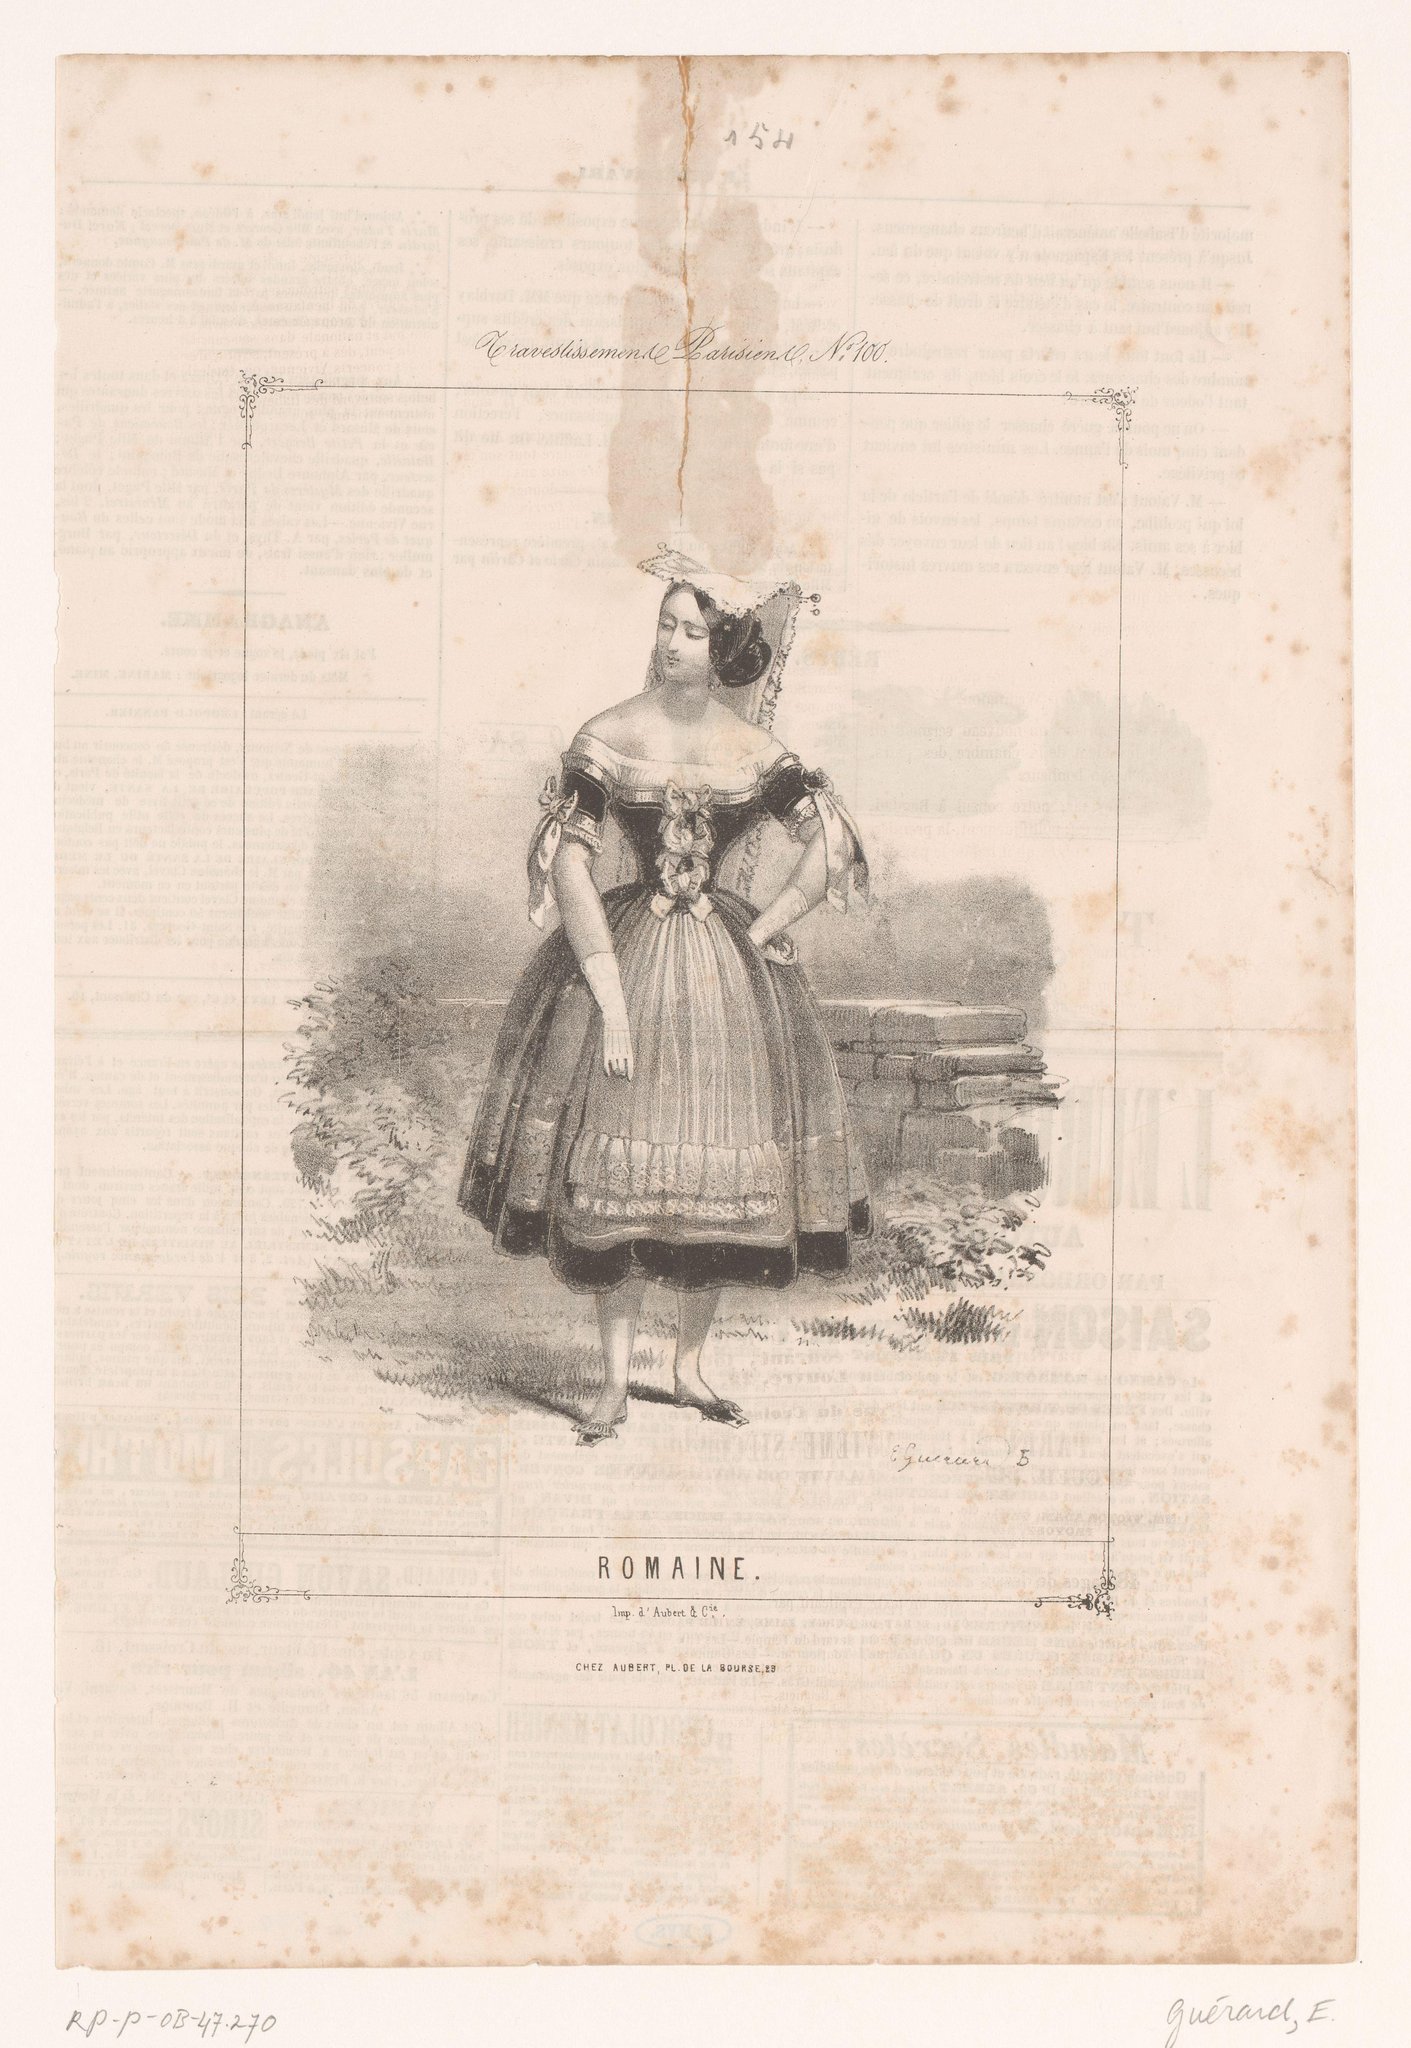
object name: print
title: Parijzenaars verkleden zich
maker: eugène guérard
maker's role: draughtsman, painter, print maker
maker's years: 1821-1866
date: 1844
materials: paper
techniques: lithograph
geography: paris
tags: folk costume, regional costume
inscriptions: collector's mark: Lugt 2228a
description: Prent gebruikt voor: Le Charivari, 1844.